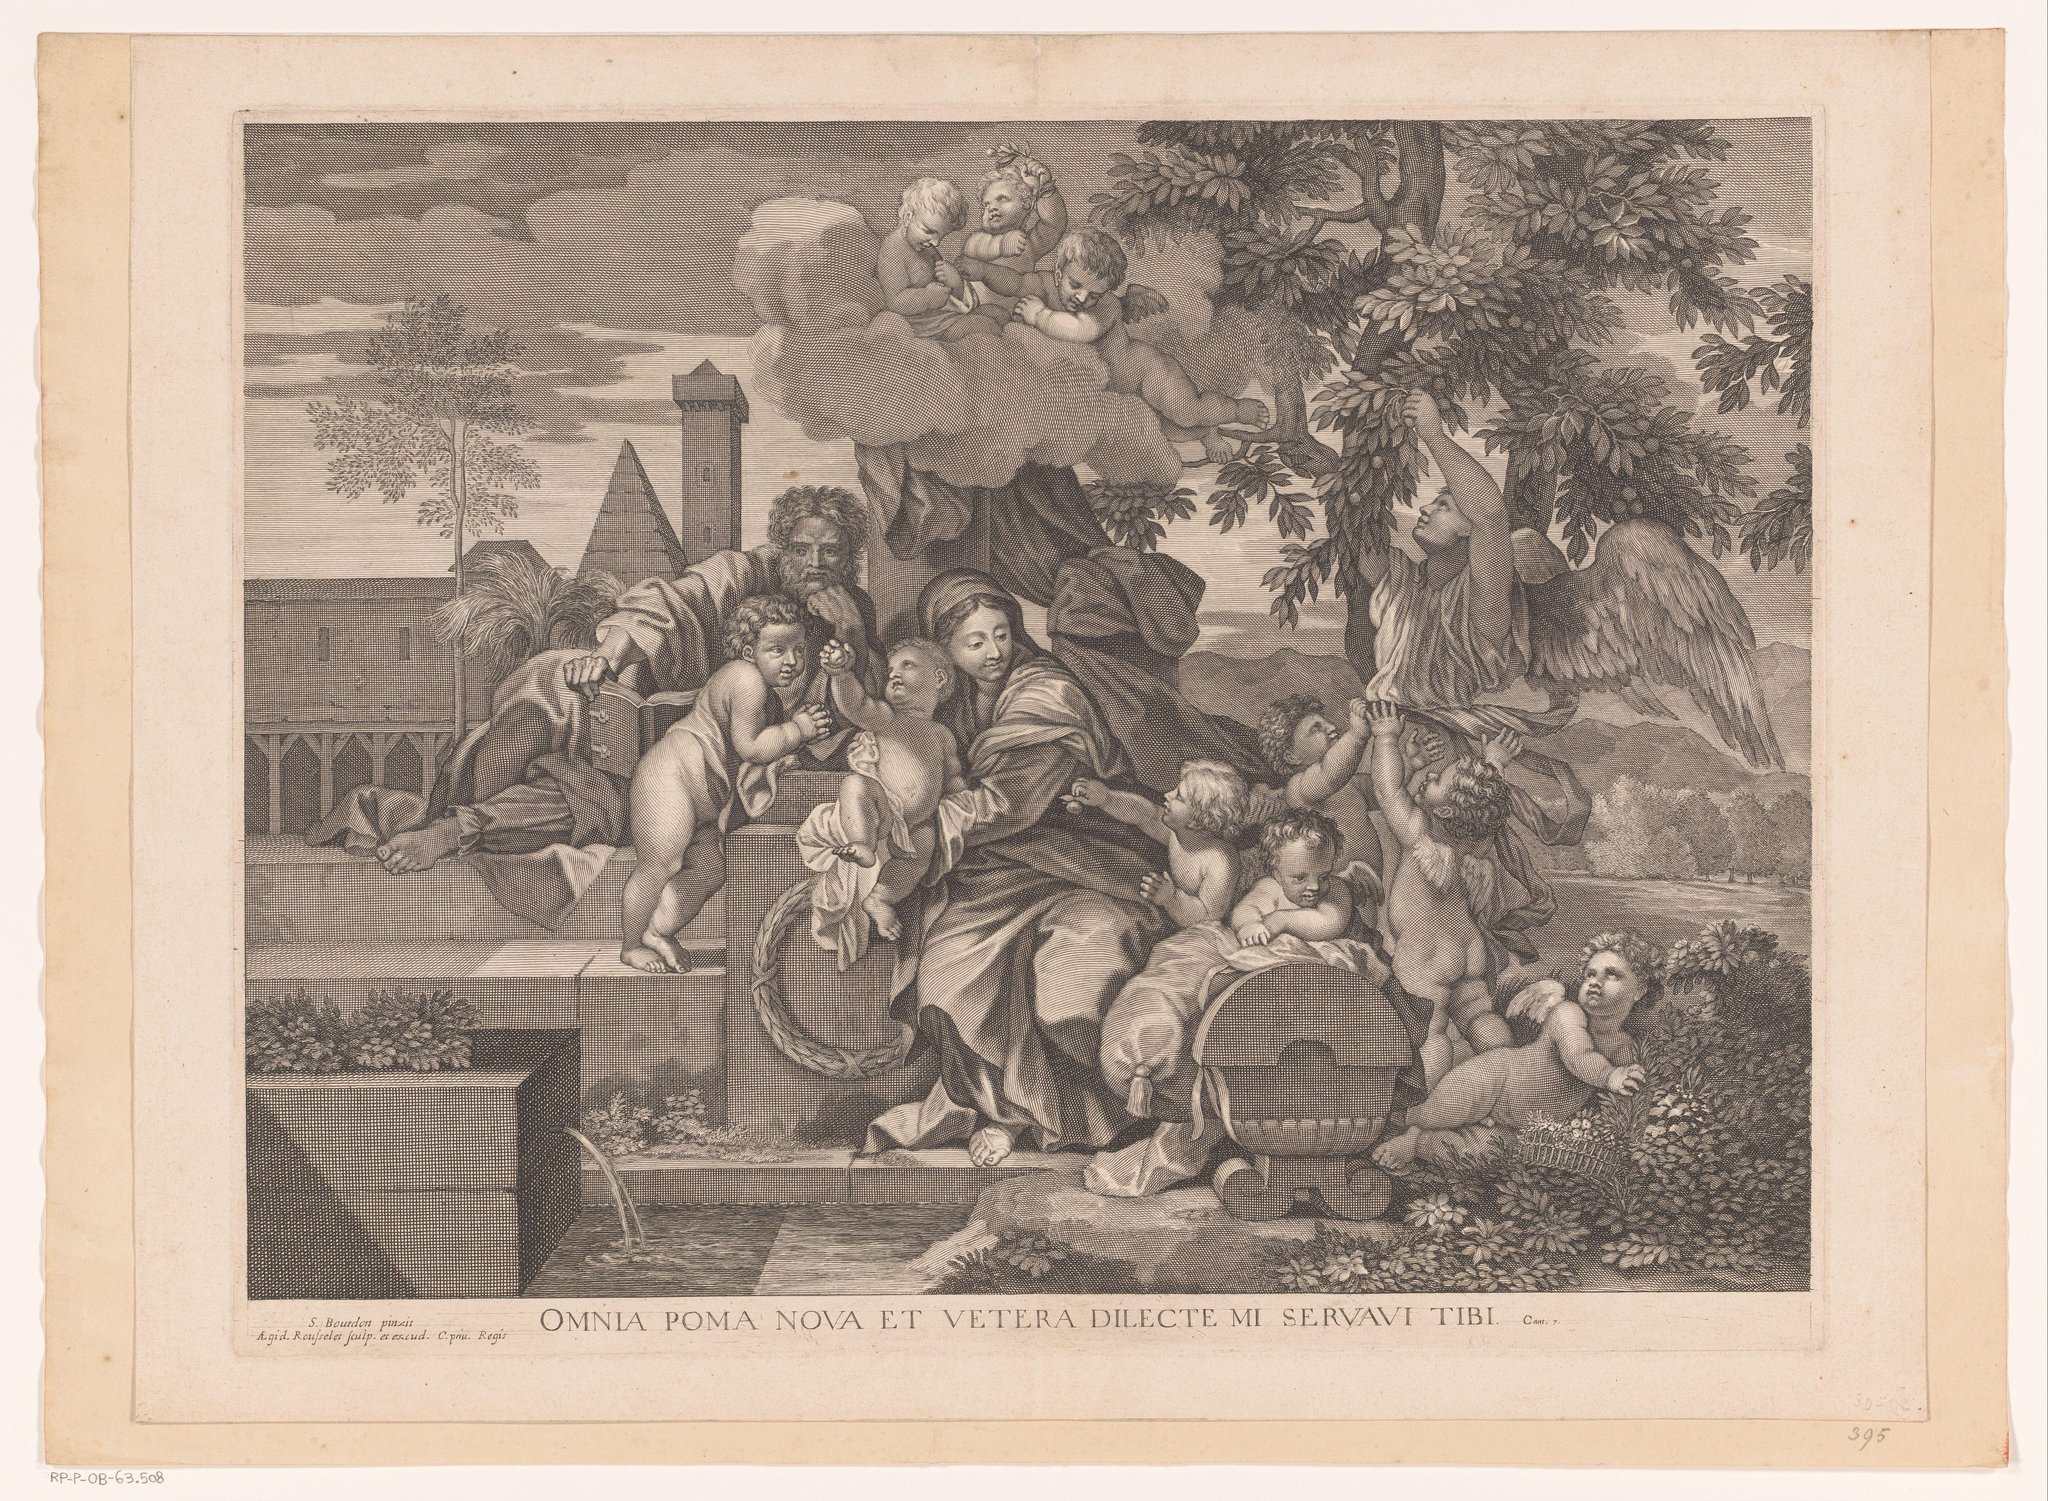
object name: print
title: Heilige Familie met putti bij appelboom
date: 1650-1655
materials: paper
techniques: engraving, etching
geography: france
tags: holy family, and derived representations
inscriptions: collector's mark: Lugt 240